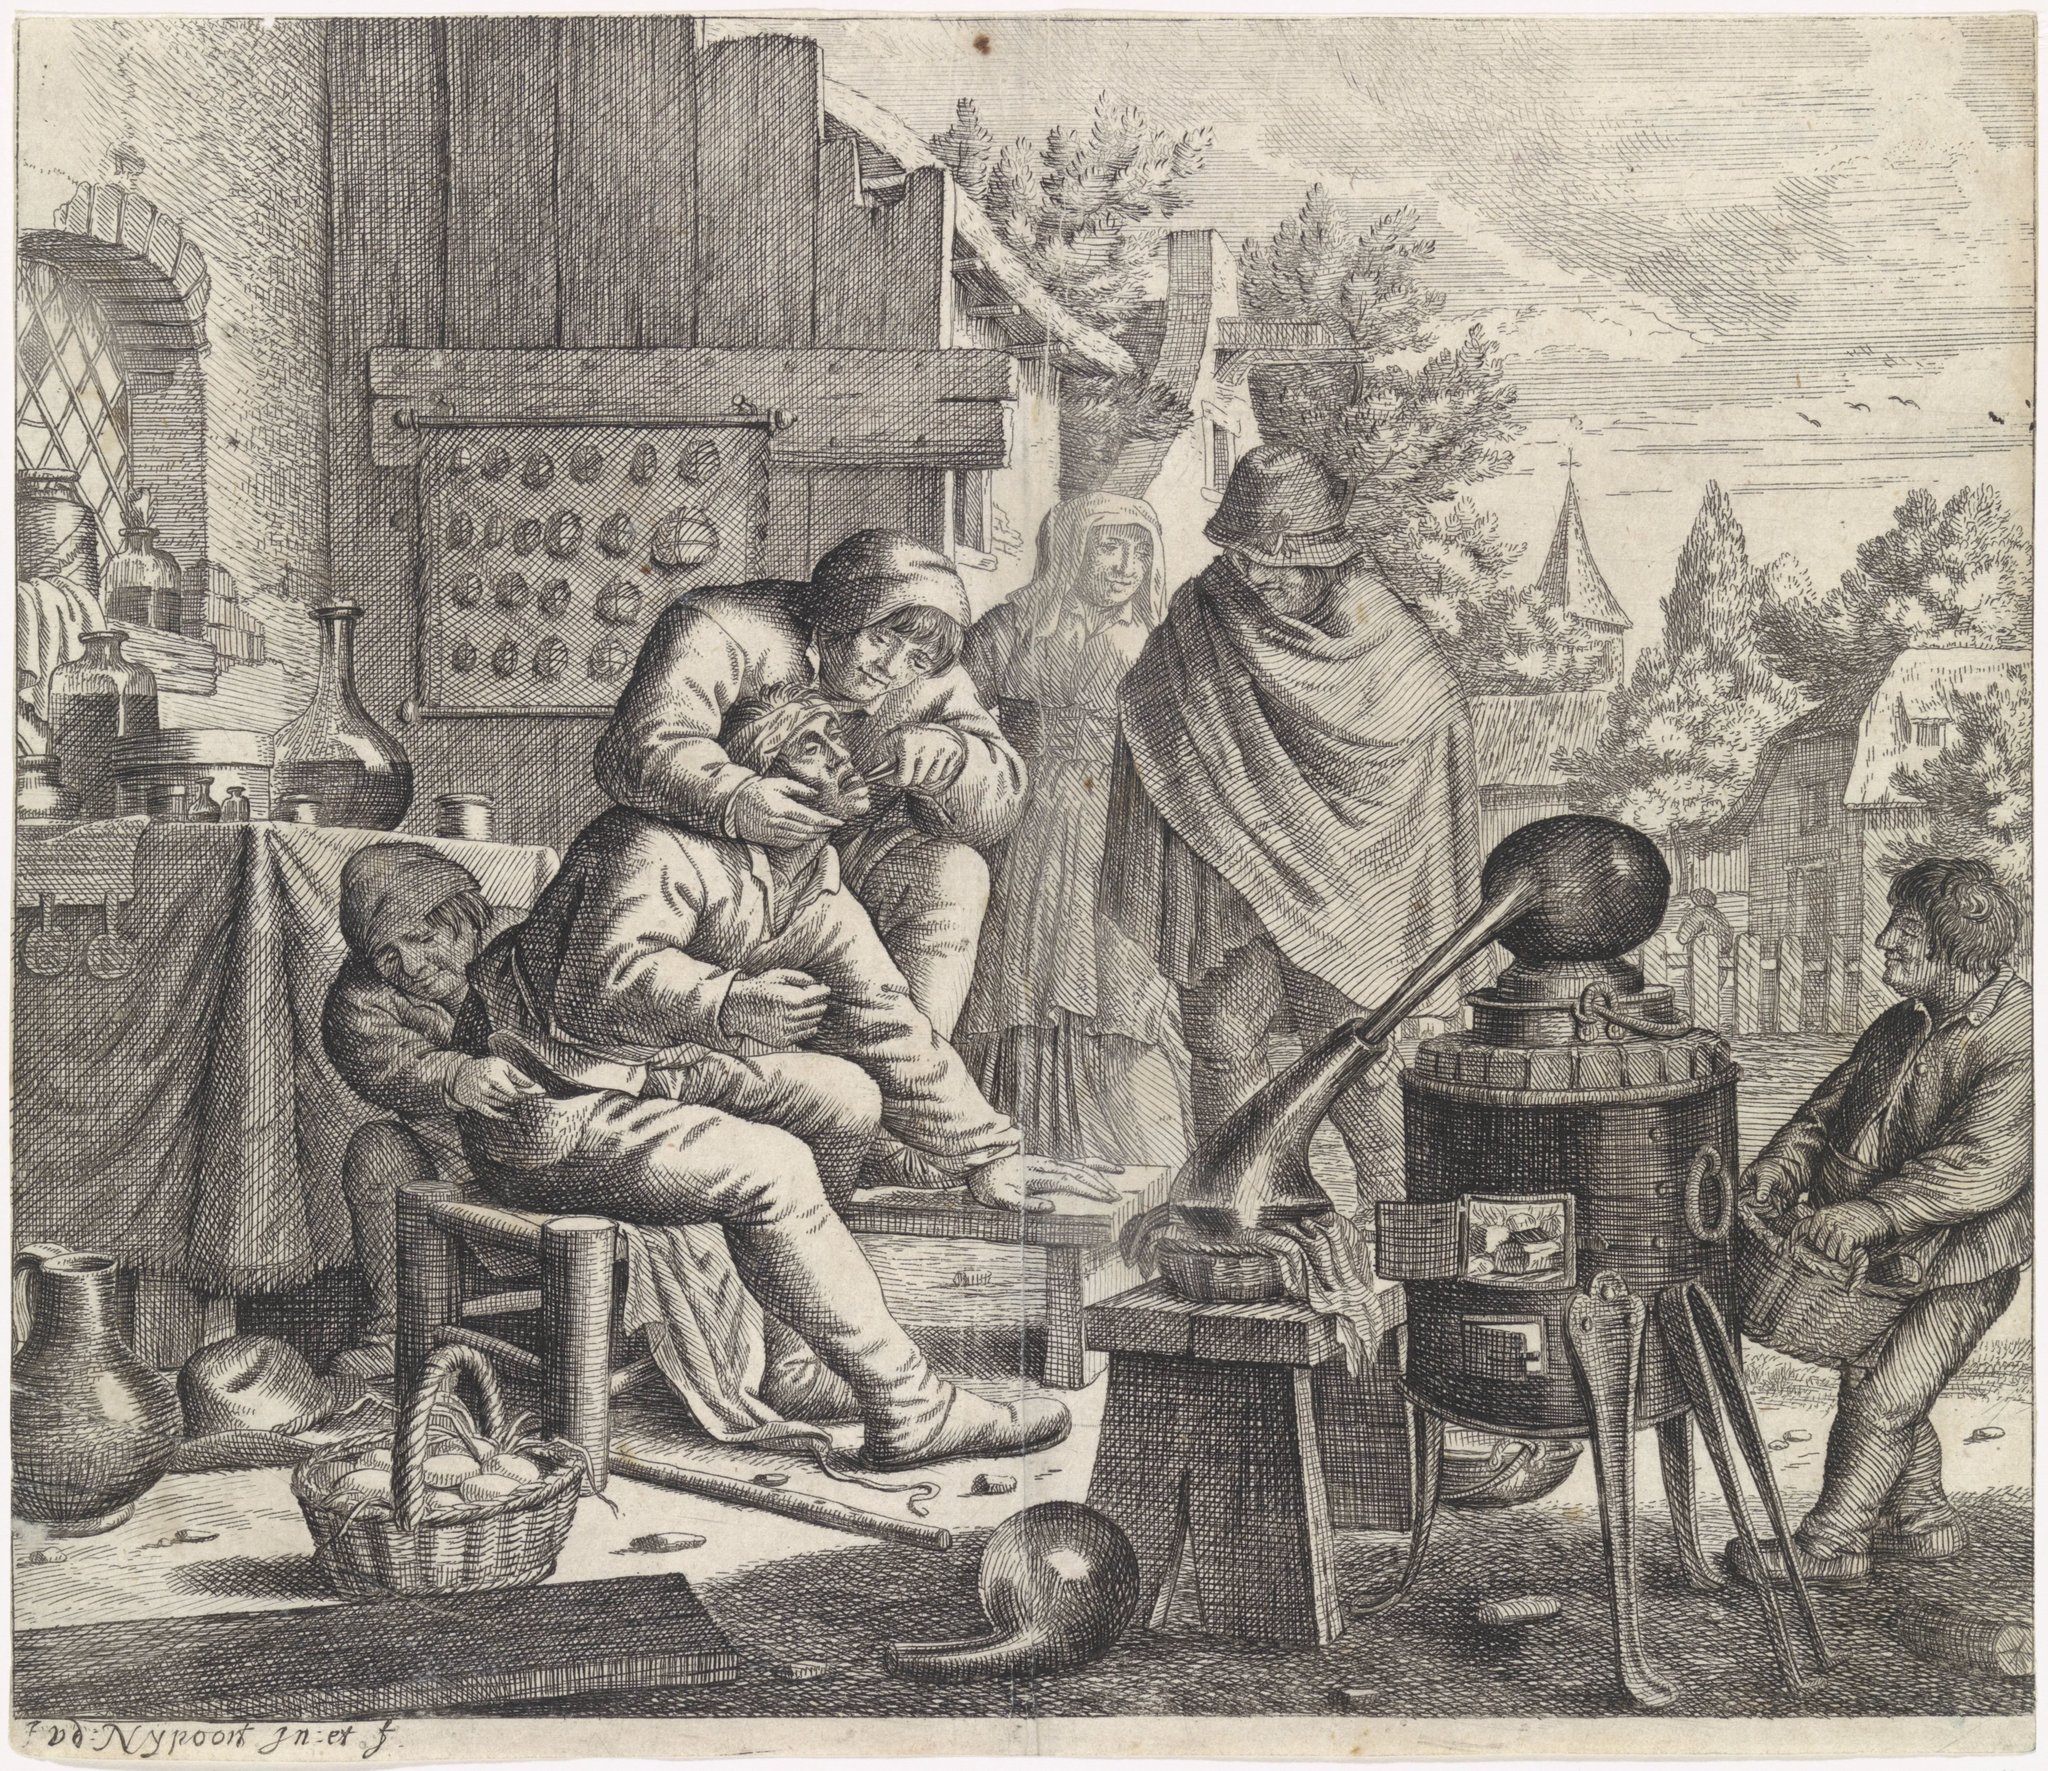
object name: print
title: Tandarts aan het werk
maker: justus van den nijpoort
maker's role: draughtsman, print maker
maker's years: 1625-1692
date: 1635-1692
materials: paper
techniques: engraving, etching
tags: pharmacist, druggist, apothecary; pharmacy, drugstore, dispensing chemist (+ inspiration), laboratory apparatus and equipment, (barber as) dentist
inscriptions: collector's mark: Lugt 2165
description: Een tandarts trekt in de buitenlucht een tand bij een boer. Ondertussen wordt de boer beroofd, door een man die in zijn buidel graait. Naast hem staat een mand met eieren op de grond. Een man en een vrouw staan achter de tandarts. Rechts staat een man met een mand in de handen bij een destilleerapparaat. Links voor het huis staan karaffen en potjes op een tafel.